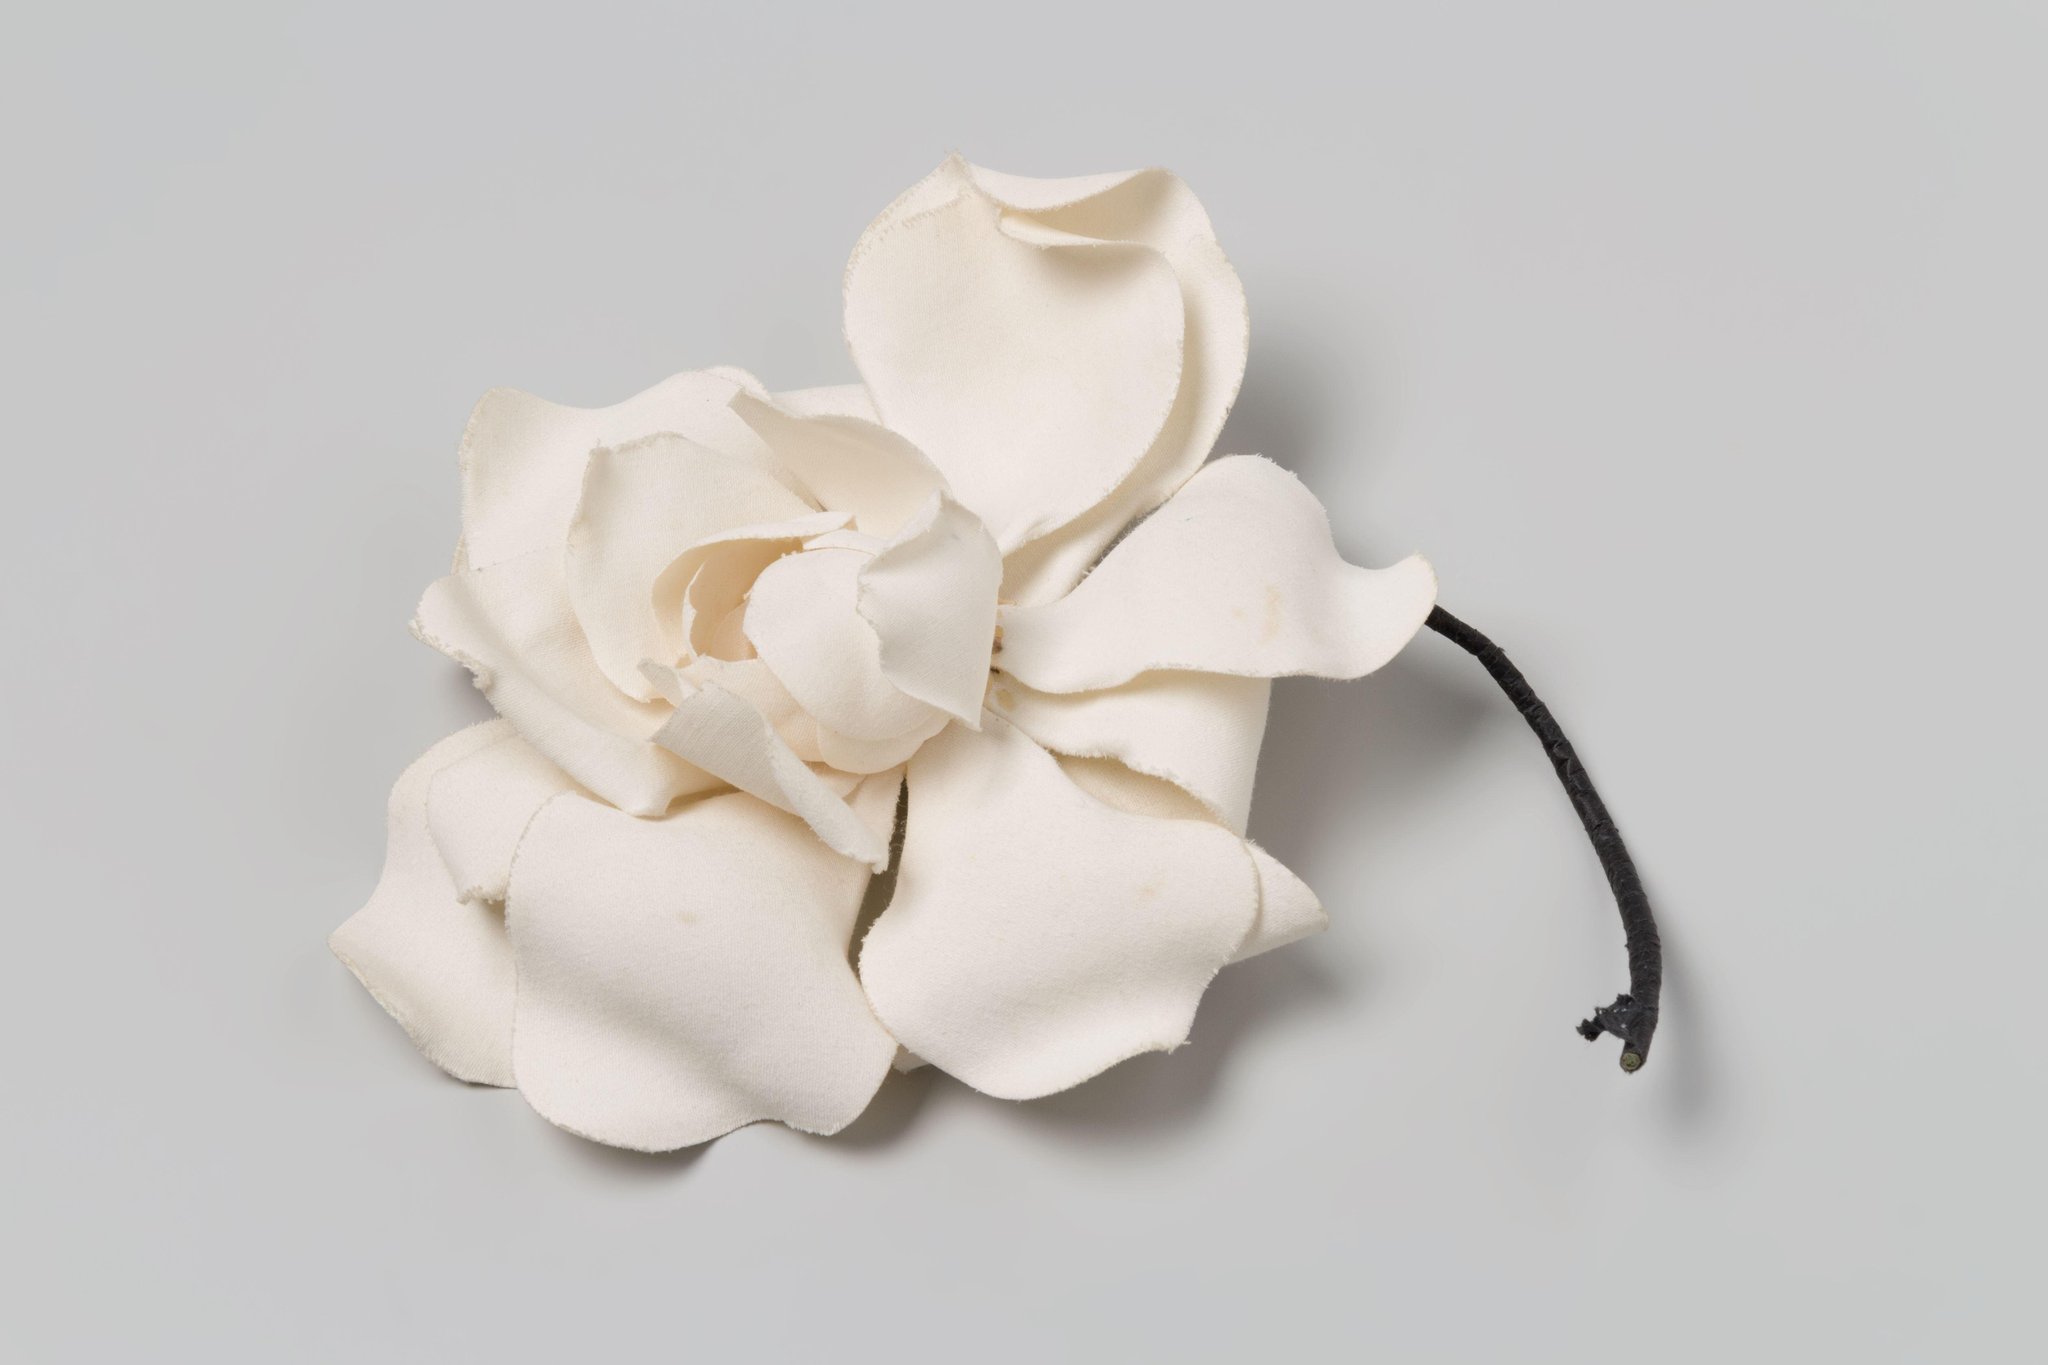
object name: womenswear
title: Corsage van witte pioenroos van linnen met steeltjes van ijzerdraad omwonden met groen papier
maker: Anonymous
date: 1930-1950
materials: linen, paper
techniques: weave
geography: netherlands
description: Bloemcorsage, witte pioenroos van linnen met steeltjes van ijzerdraad omwonden met groen papier.